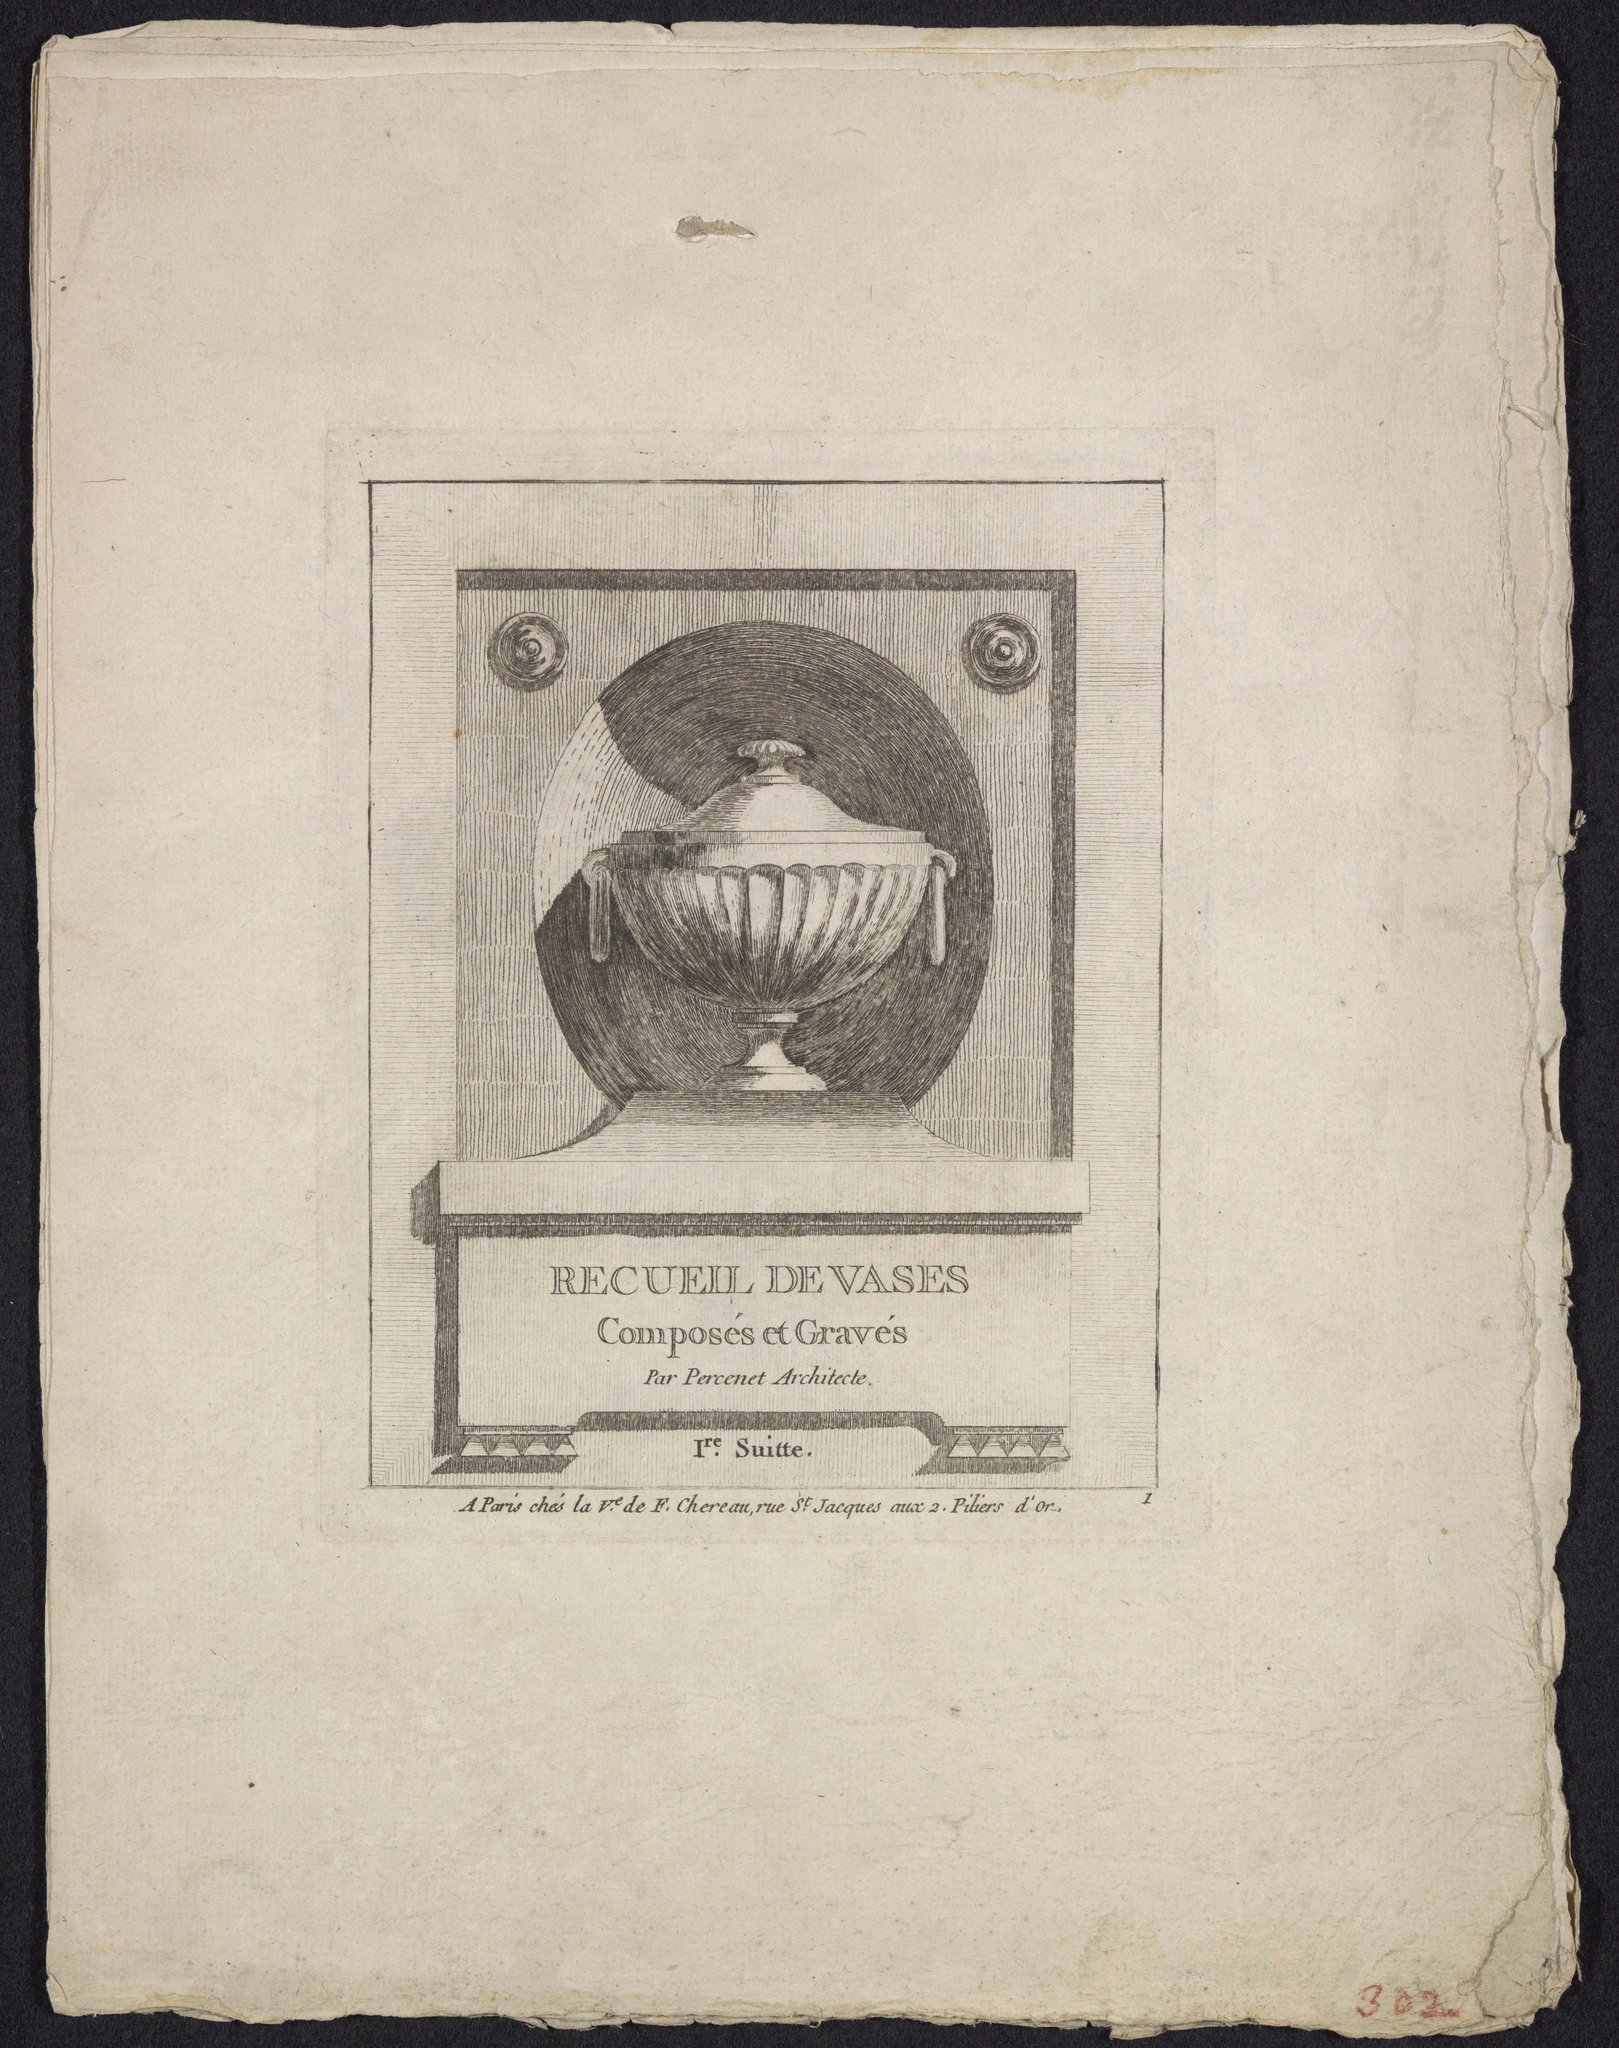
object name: print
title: Vaas in nis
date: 1755-1768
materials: paper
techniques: etching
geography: paris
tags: vase ~ ornament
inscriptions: collector's mark: Lugt 2228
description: Een geornamenteerde vaas met geschubde rand in een ronde nis op een voetstuk met serietitel.